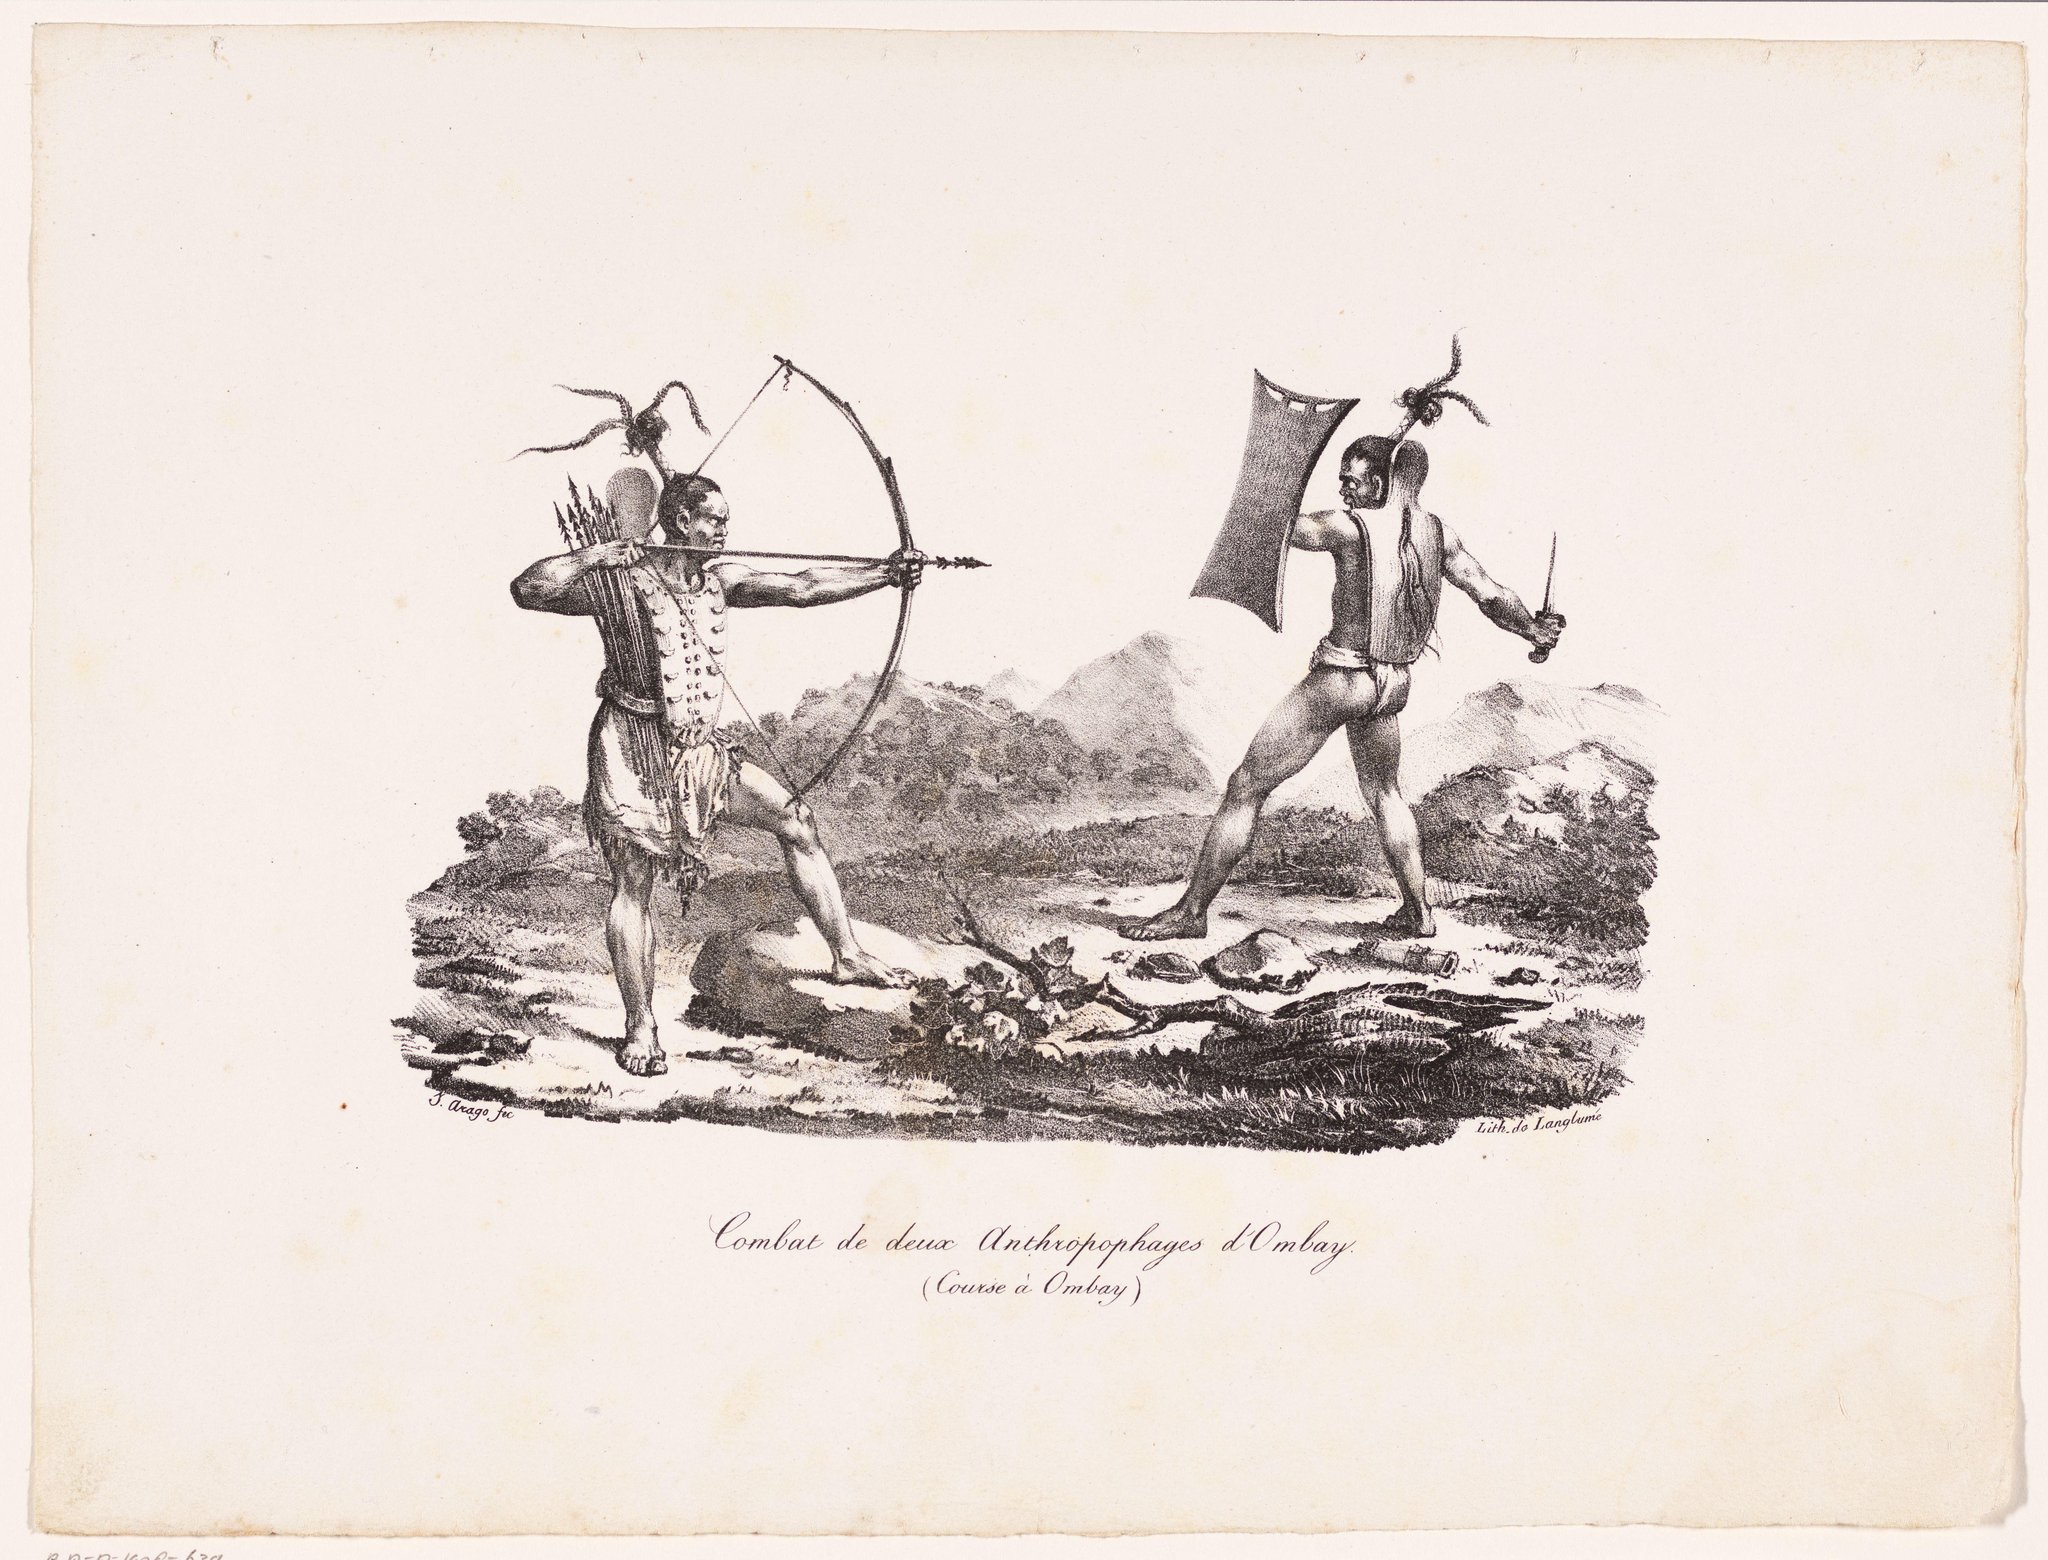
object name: print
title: Landschappen en volken gezien tijdens een wereldreis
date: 1822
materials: paper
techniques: lithograph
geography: paris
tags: asiatic races and peoples, battle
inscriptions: collector's mark: Lugt 2228a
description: Prent mogelijk uit een album dat is uitgegeven bij: Arago, J.E.V. Promenade autour de monde pendant les années 1817, 1818, 1819 et 1820, sur les corvettes du roi l'Uranie et la Physicienne, commandées par M. Freycinet. 2 dln. Parijs: Leblanc, 1822.